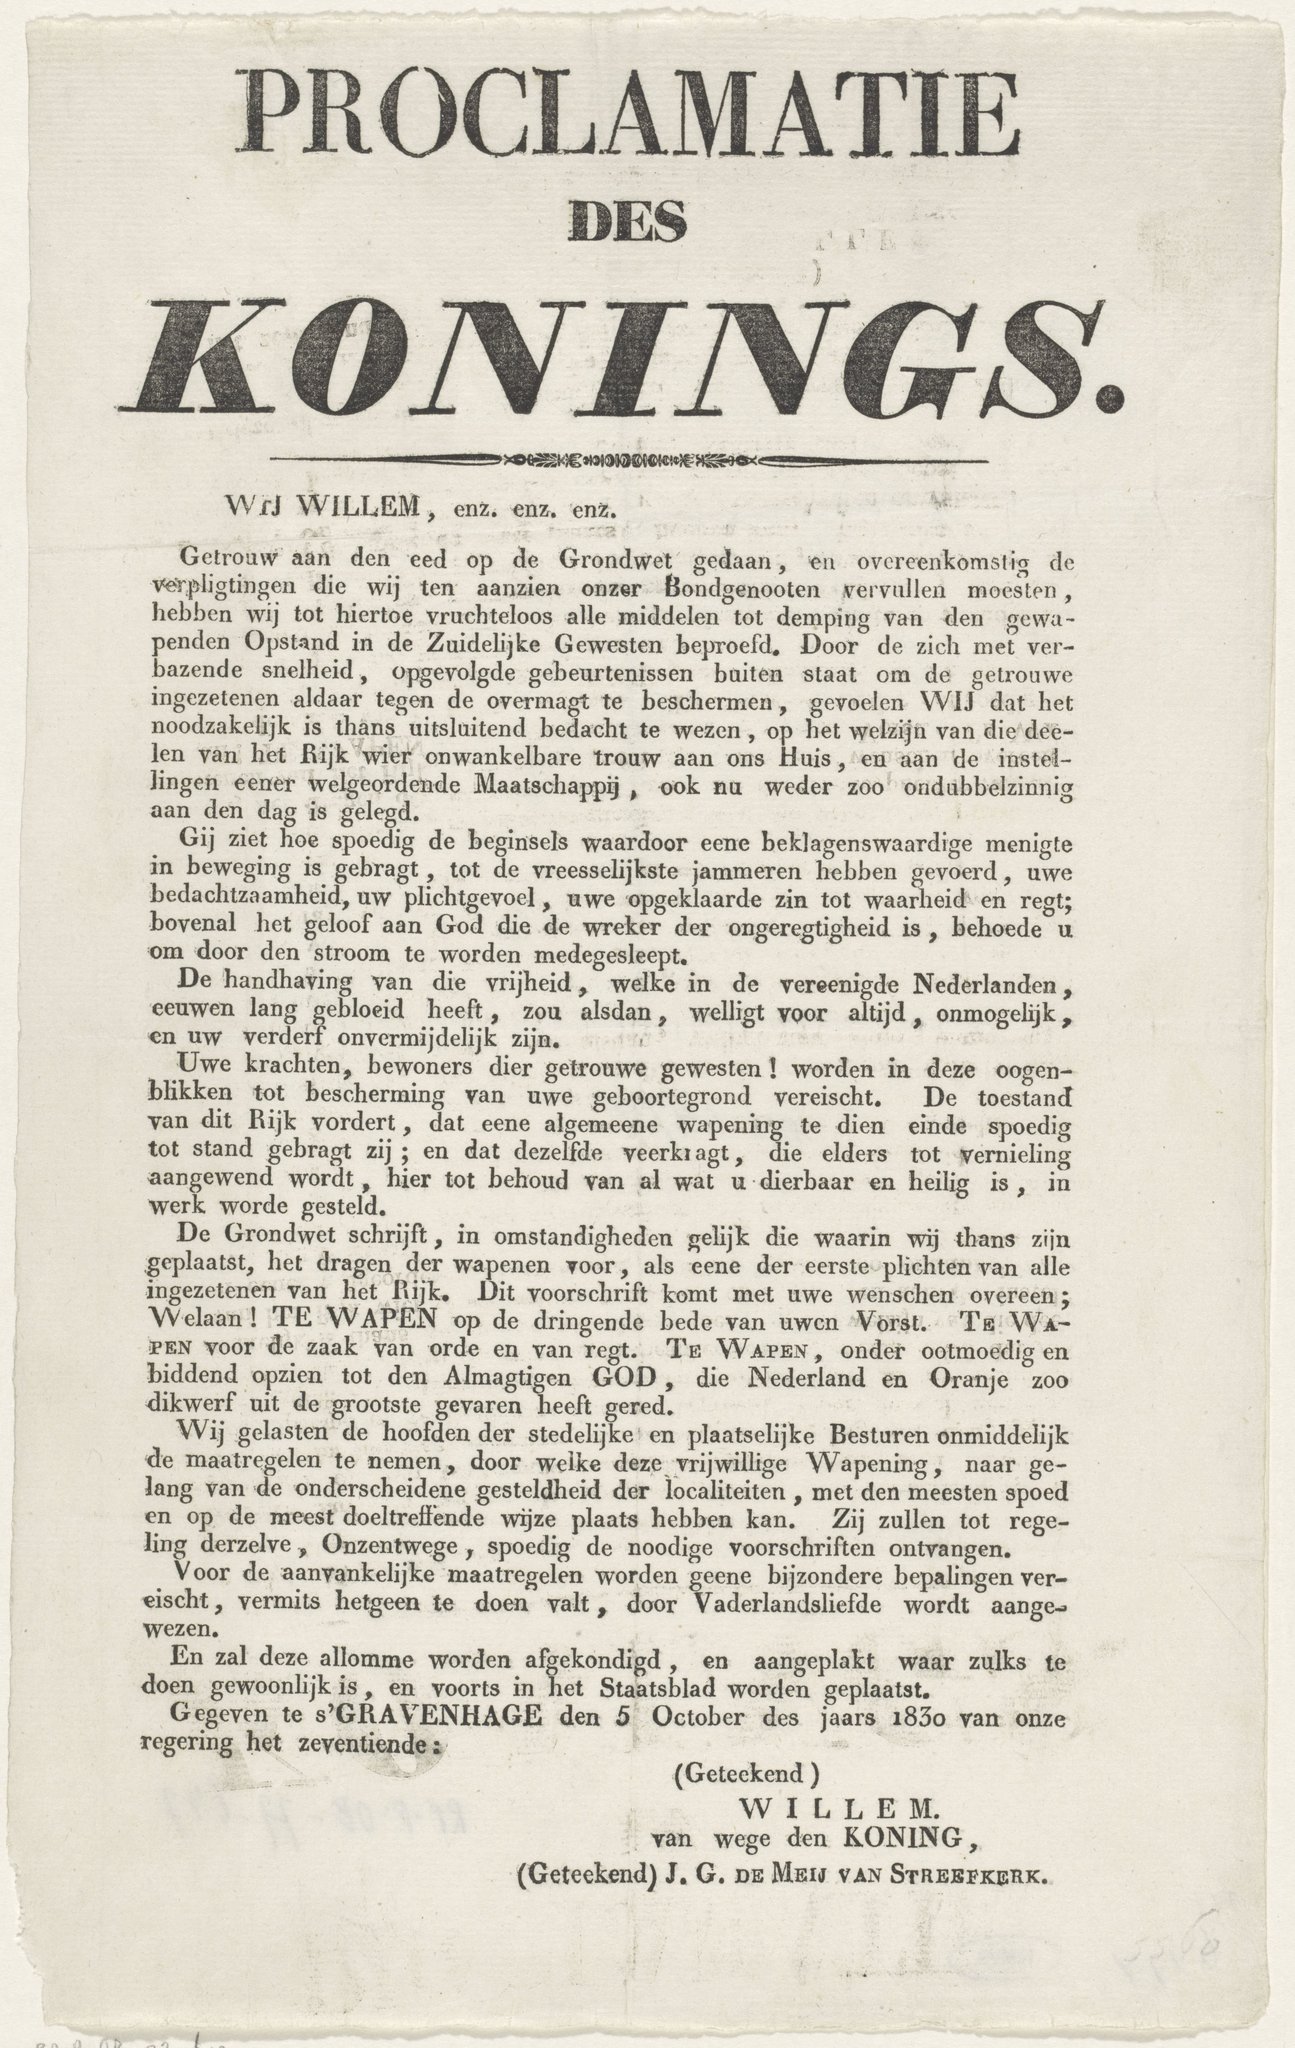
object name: text sheet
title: Proclamatie van de koning met oproep tot vrijwillige wapening, 1830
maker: Anonymous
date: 1830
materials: paper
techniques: letterpress printing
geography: the hague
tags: the hague, william i of the netherlands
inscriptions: collector's mark: Lugt 2228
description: Proclamatie in naam van koning Willem I, waarin de oproep tot vrijwillige wapening van de burgers, 5 oktober 1830. Naar aanleiding van de gewapende opstand in de zuidelijke gewesten.